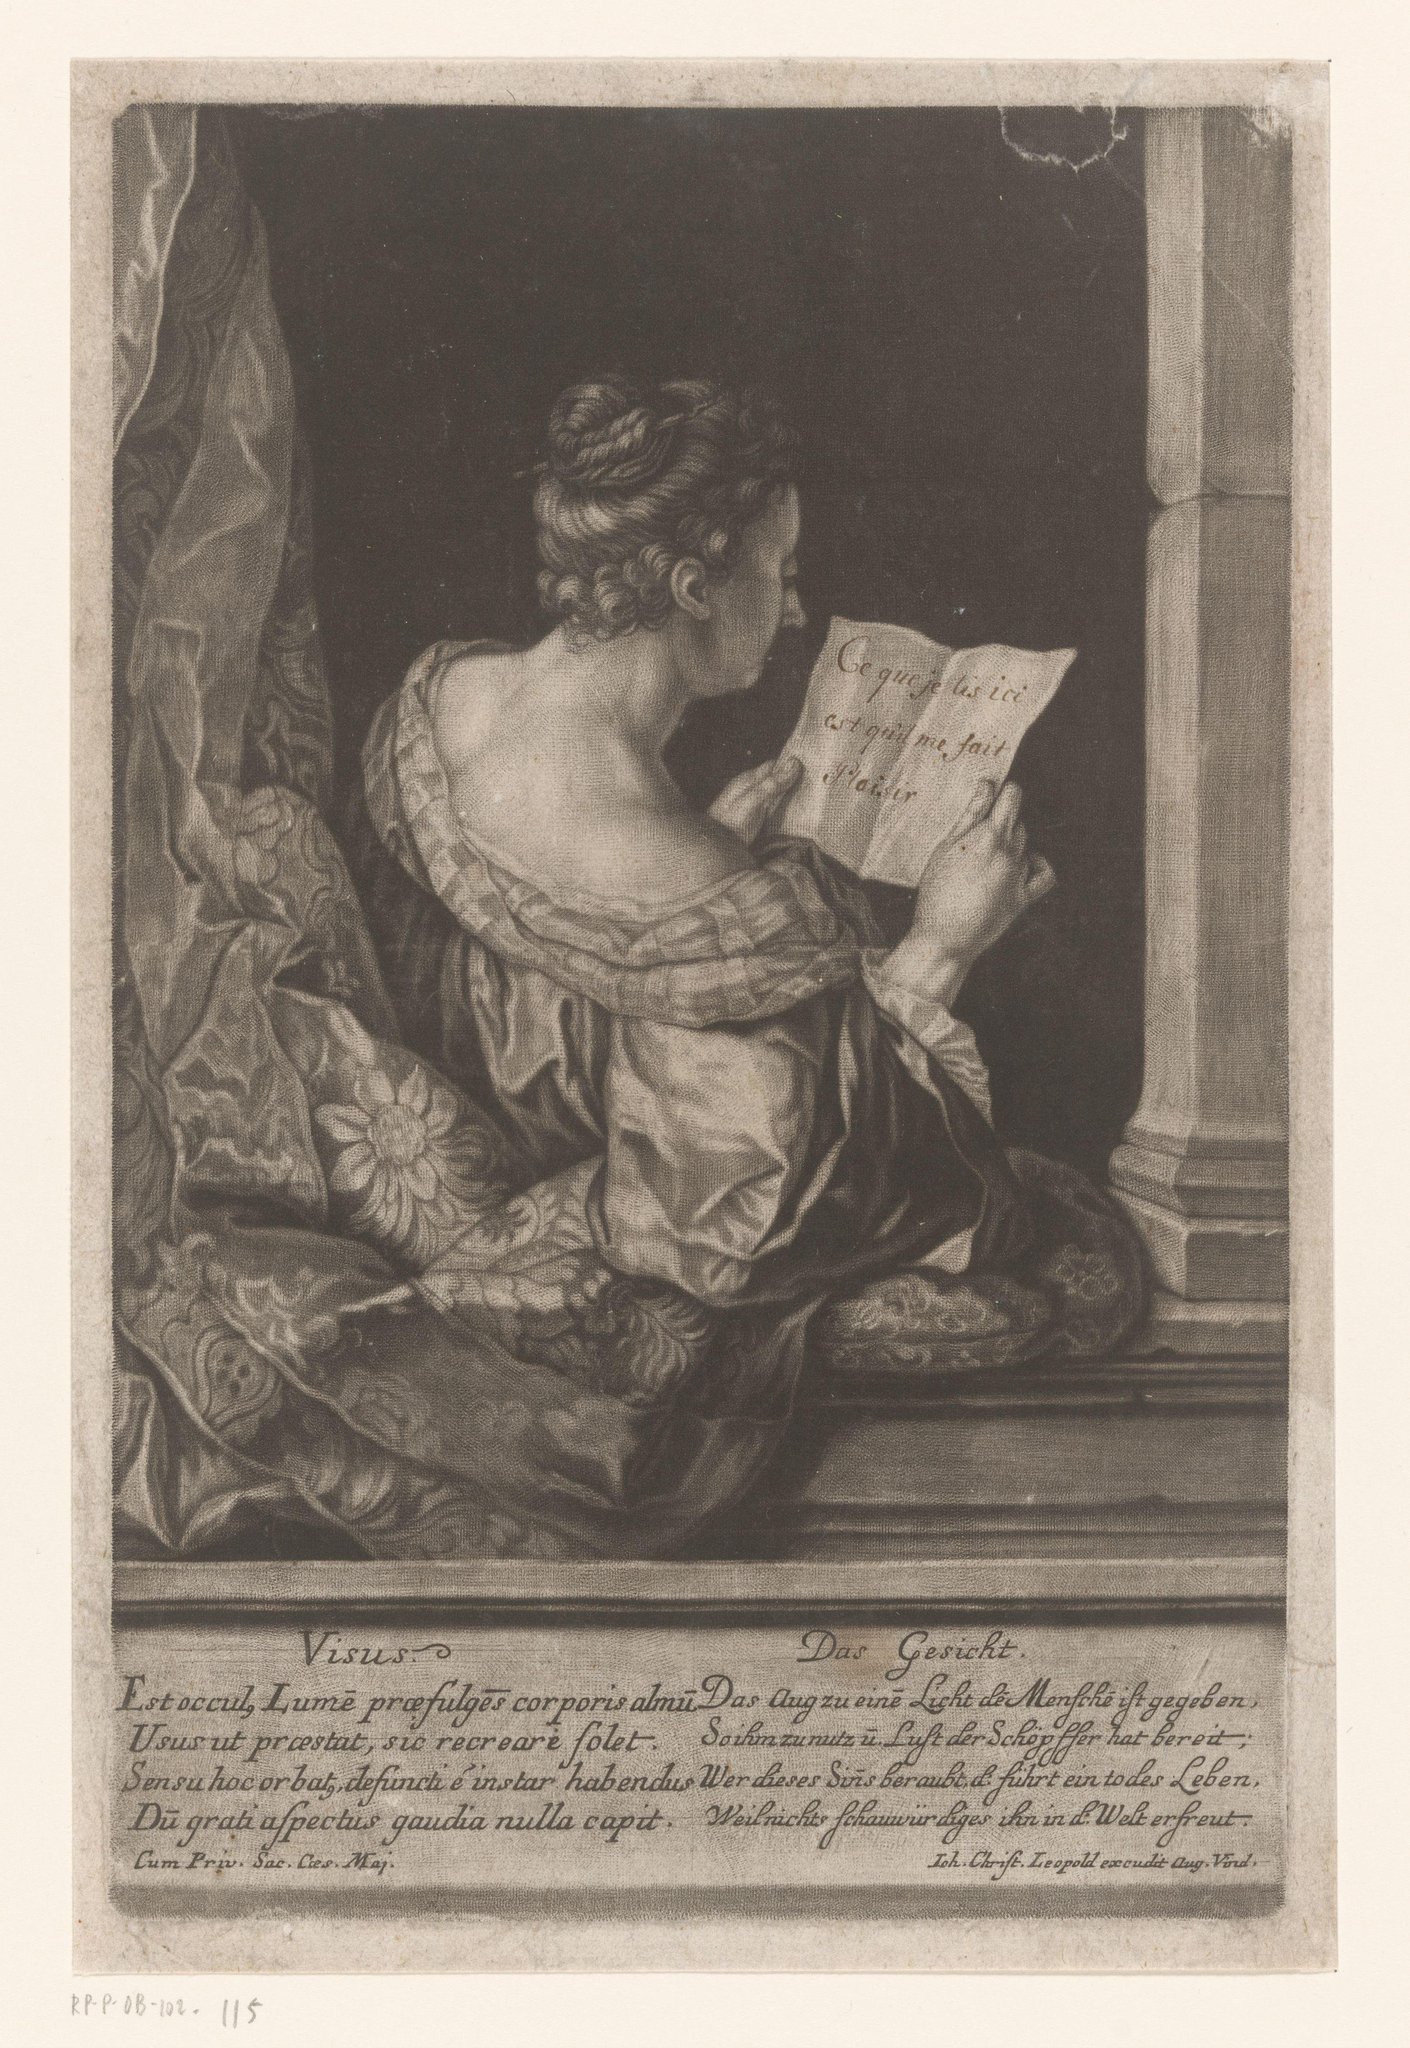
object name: print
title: Visus / Das Gesicht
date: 1709-1755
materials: paper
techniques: mezzotint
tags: reading, sight, looking (one of the five senses), lover with love-letter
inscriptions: collector's mark: Lugt 2228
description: Een dame, van opzij gezien door een venster, naar rechts gekeerd, leest een brief met de tekst Ce que je lis ici est qui me fait Plaisir.